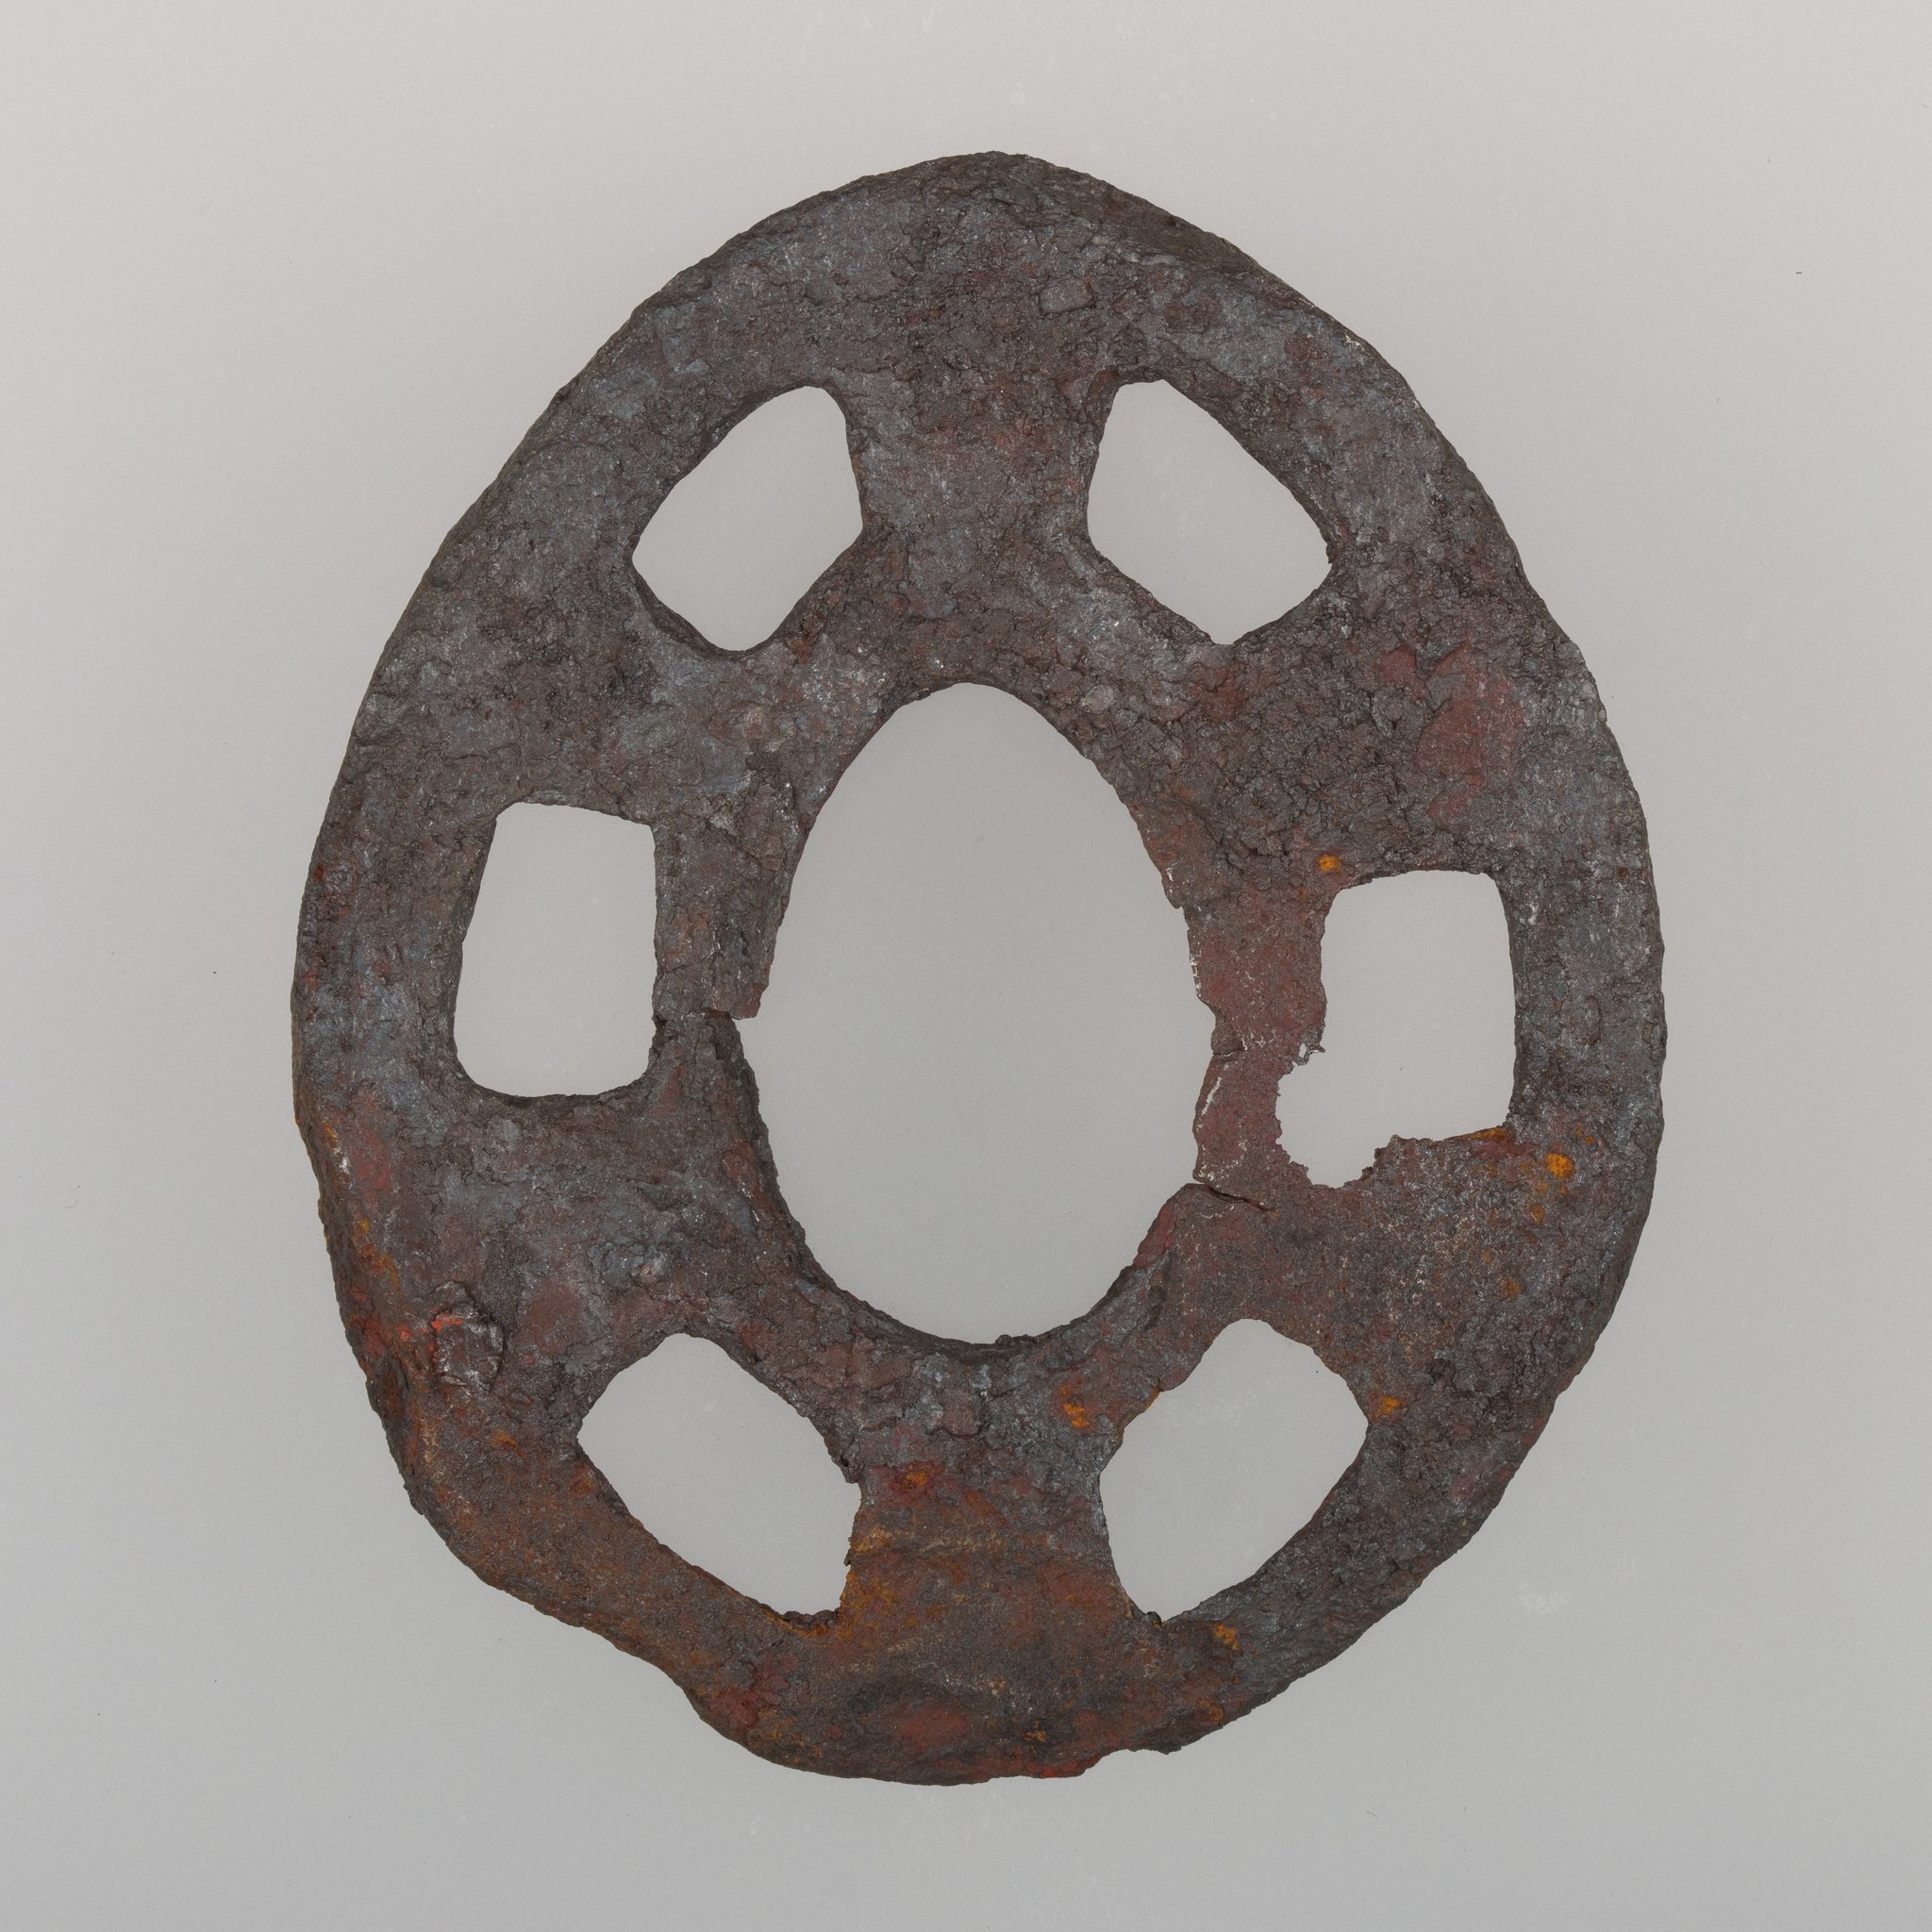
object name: sword guard tsuba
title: Sword Guard (Tsuba)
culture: japanese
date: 300-710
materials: iron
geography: japan